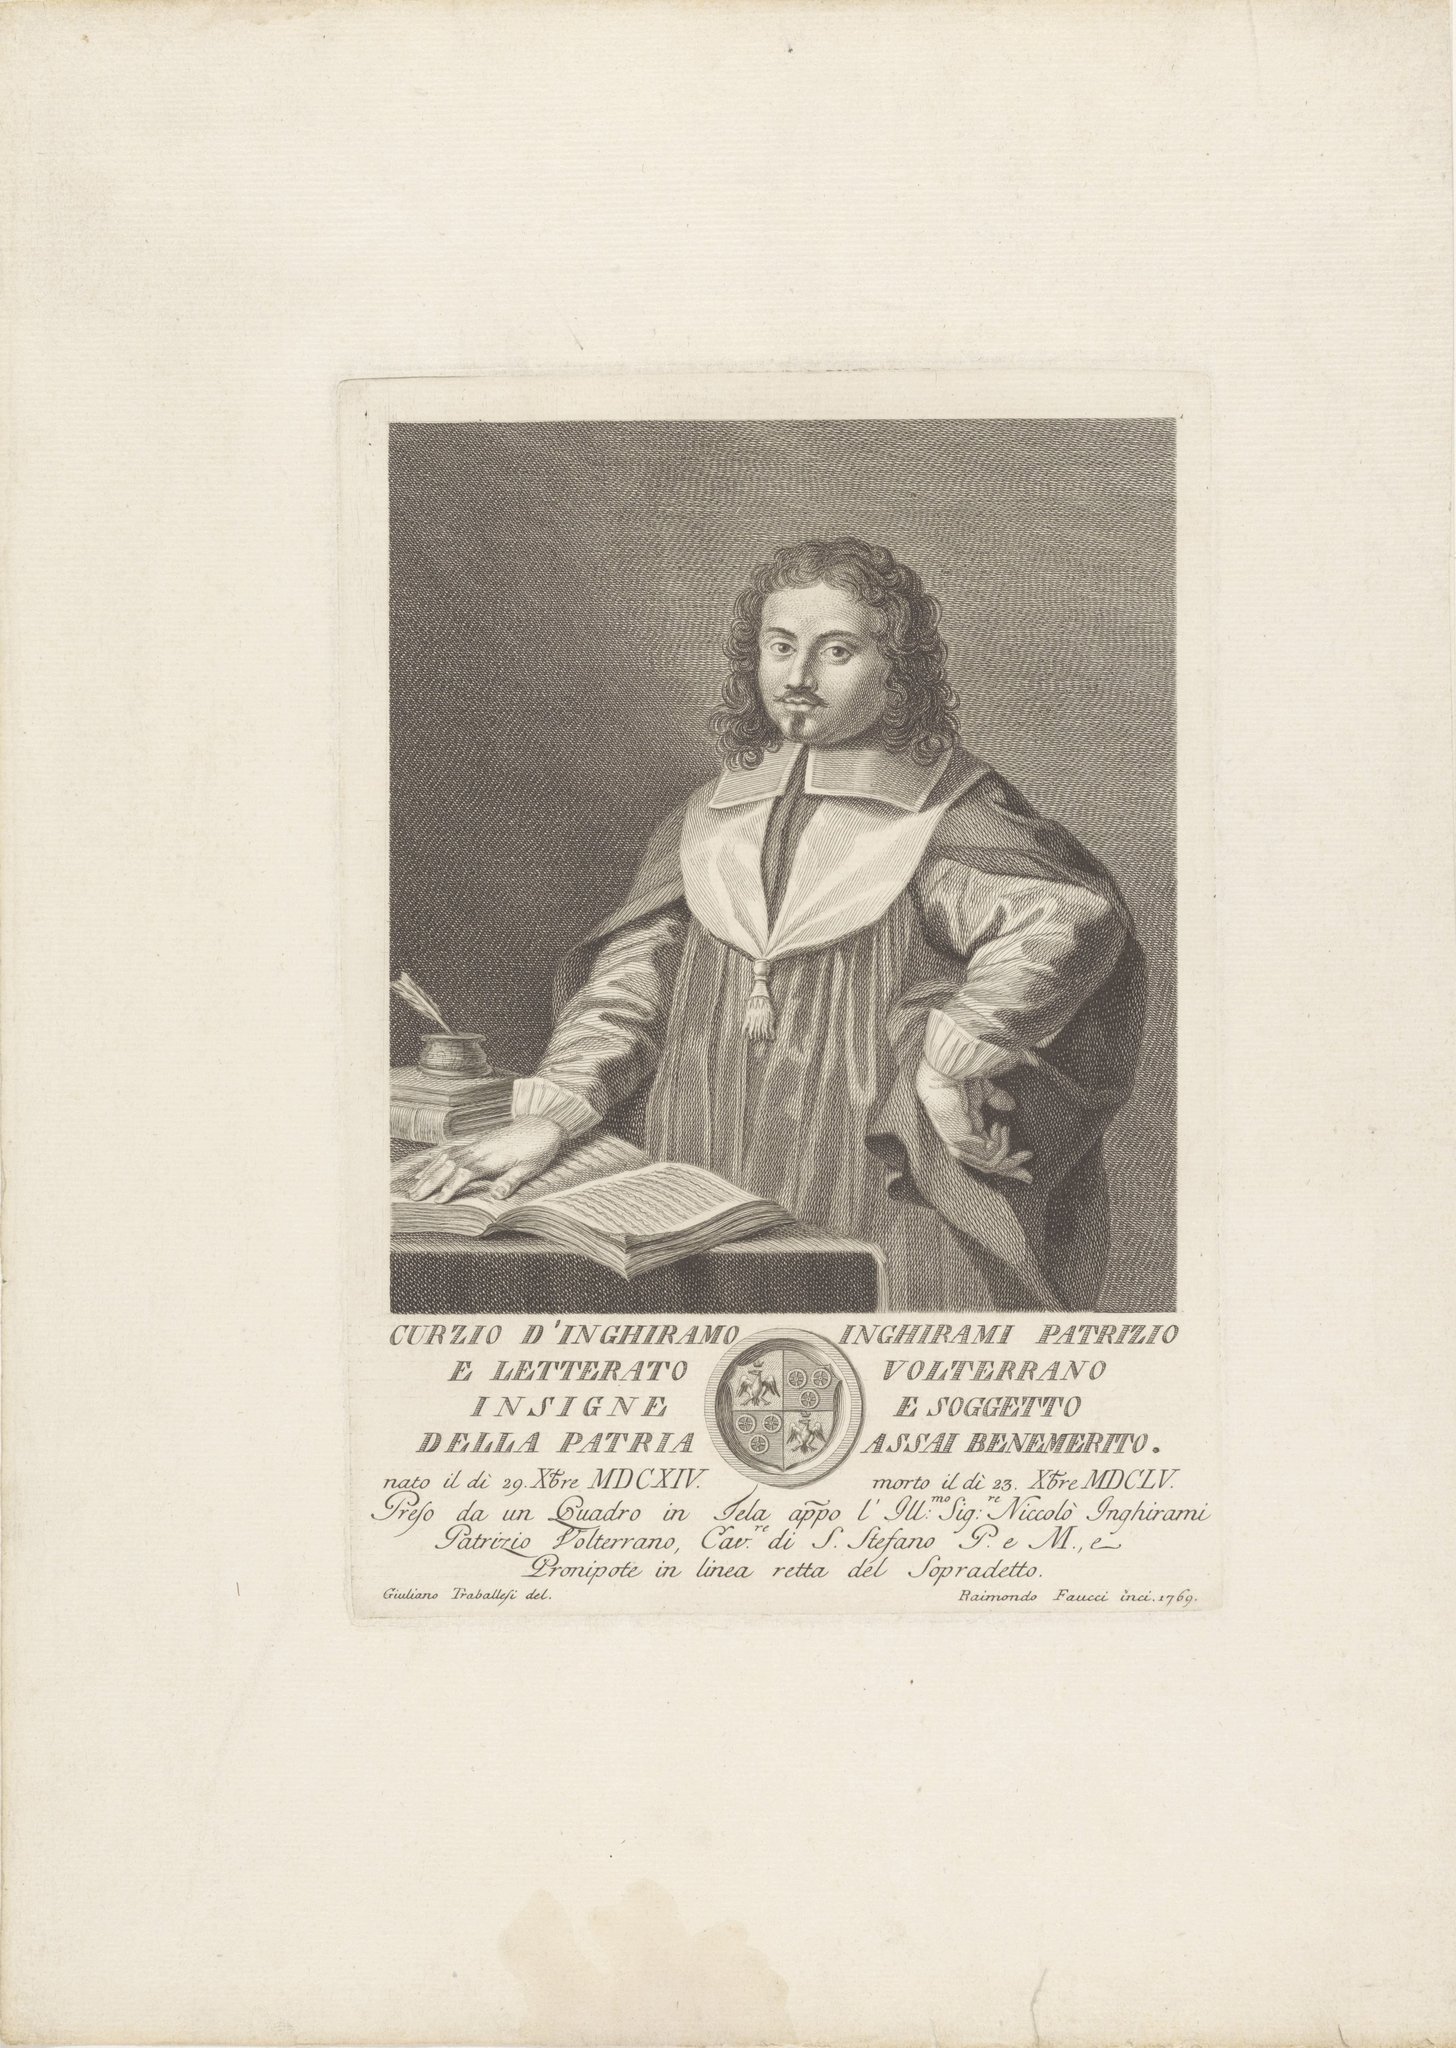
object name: print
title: Portret van Inghiramo Inghirami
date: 1769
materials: paper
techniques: engraving, etching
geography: italy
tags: historical persons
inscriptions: collector's mark: Lugt 2228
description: Deze prent maakt deel uit van een reeks portretprenten van onbekende omvang. De prenten zijn gemaakt door meedere prentmakers, onder wie Francesco Allegrini en Carlo en Raimondo Faucci.